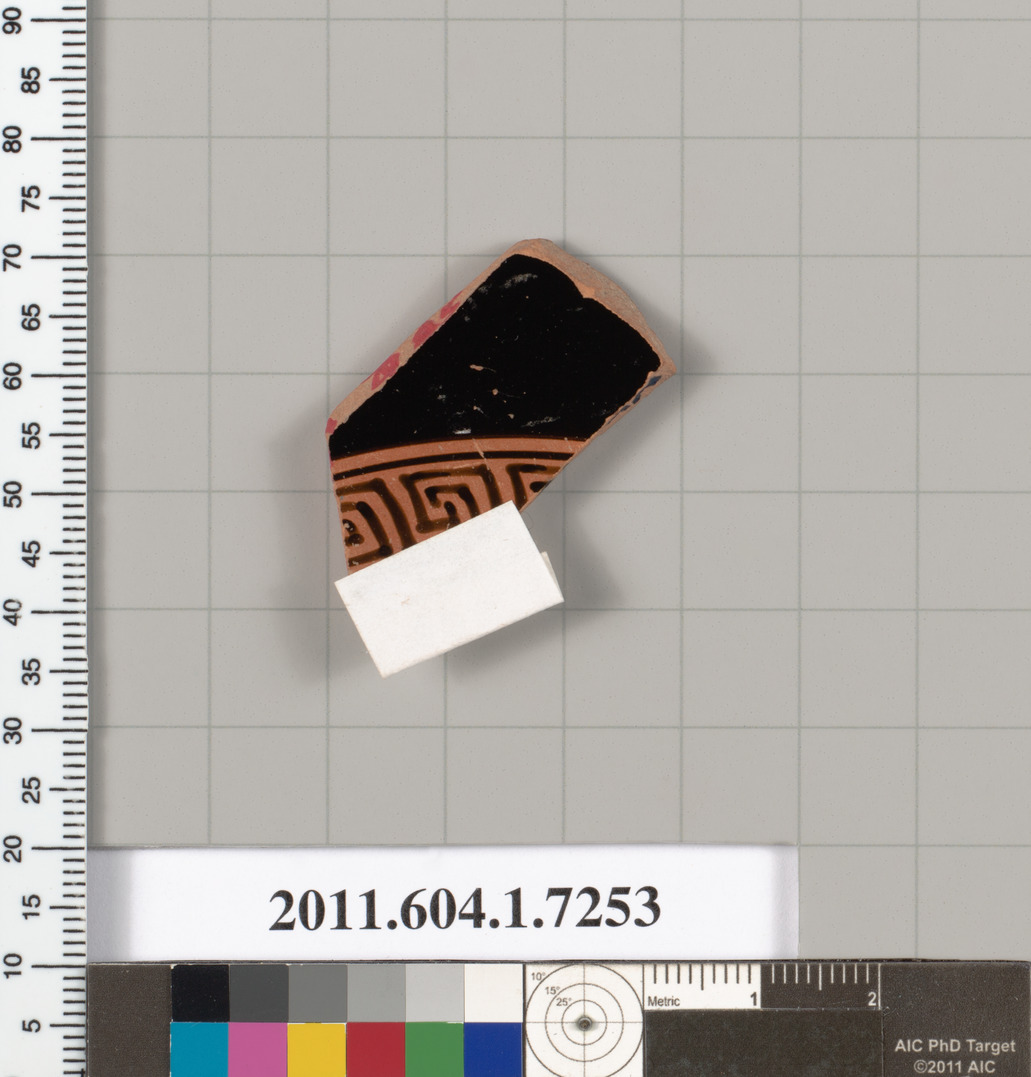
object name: kylix fragment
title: Terracotta fragment of a kylix (drinking cup)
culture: greek, attic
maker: makron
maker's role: artist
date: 500-480 BCE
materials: terracotta